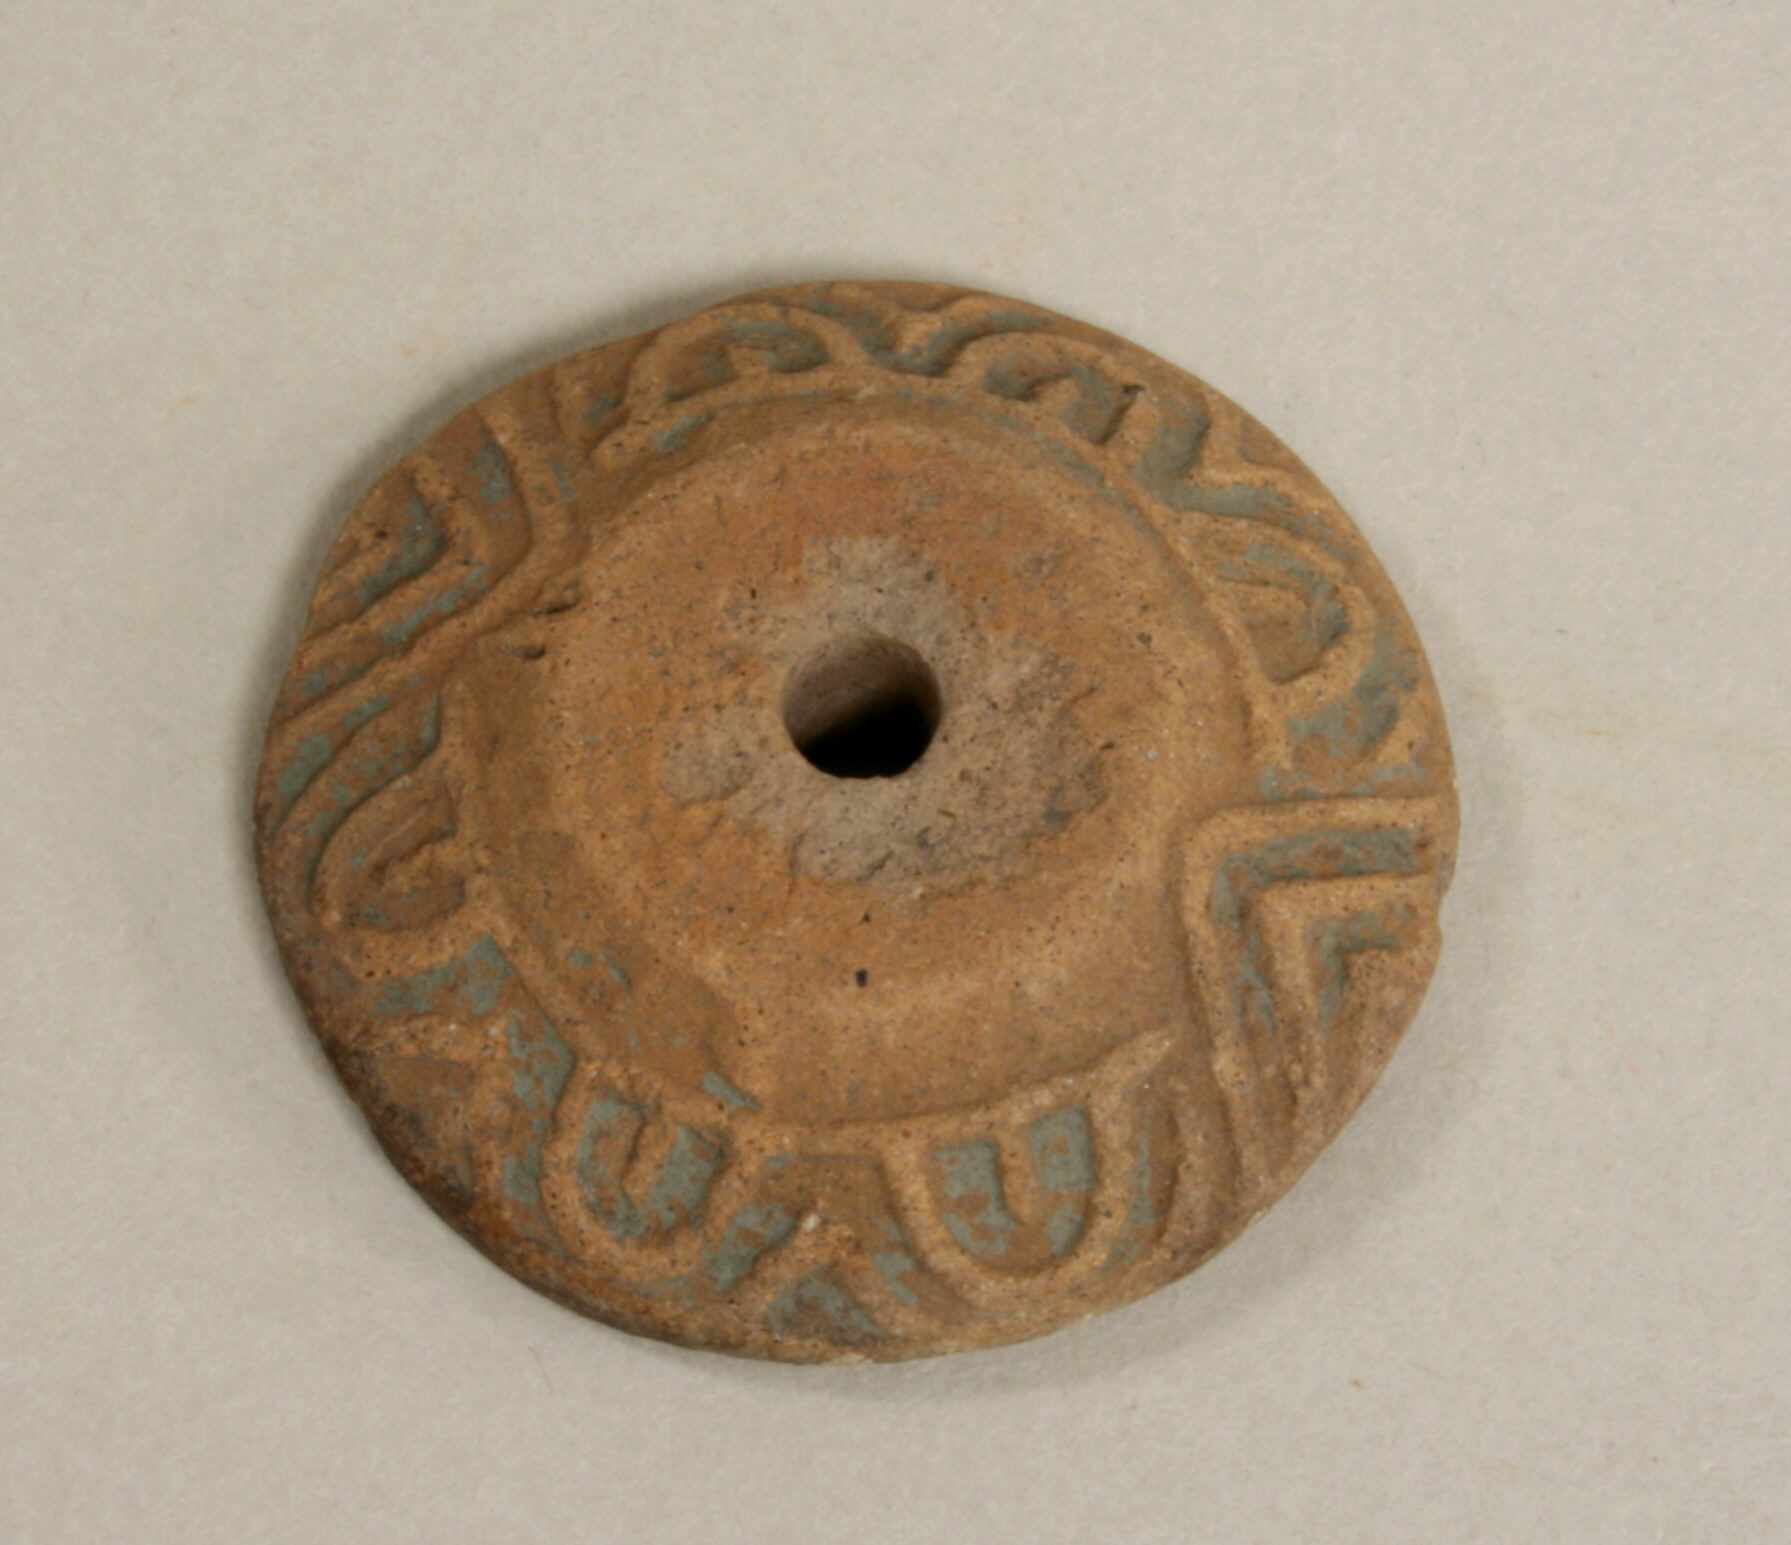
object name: spindle whorl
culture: mexican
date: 801-1500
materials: ceramic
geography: mexico